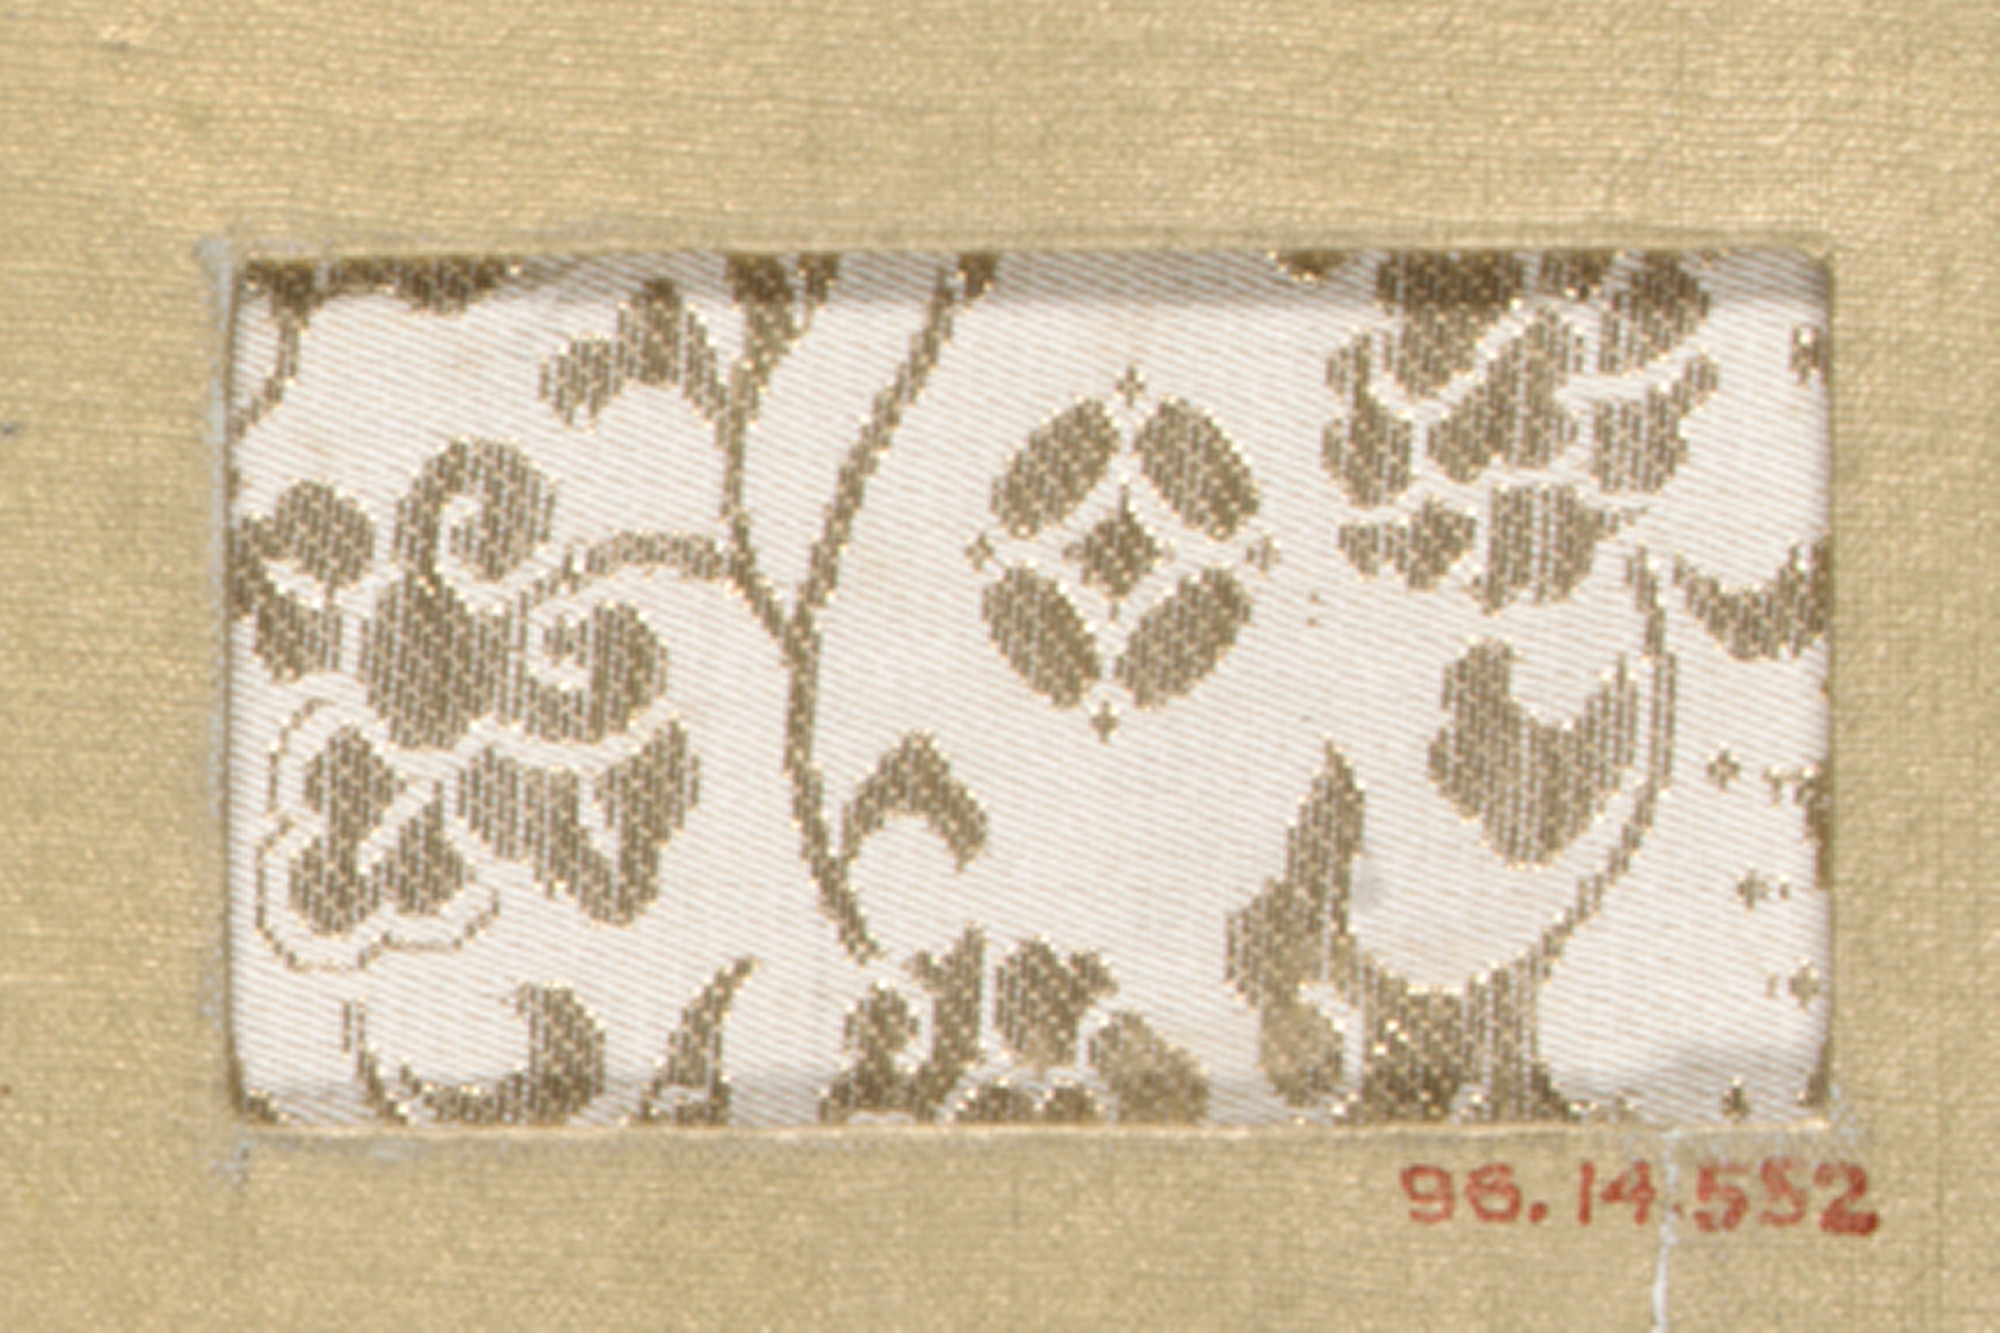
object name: piece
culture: japanese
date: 1701-1900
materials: silk